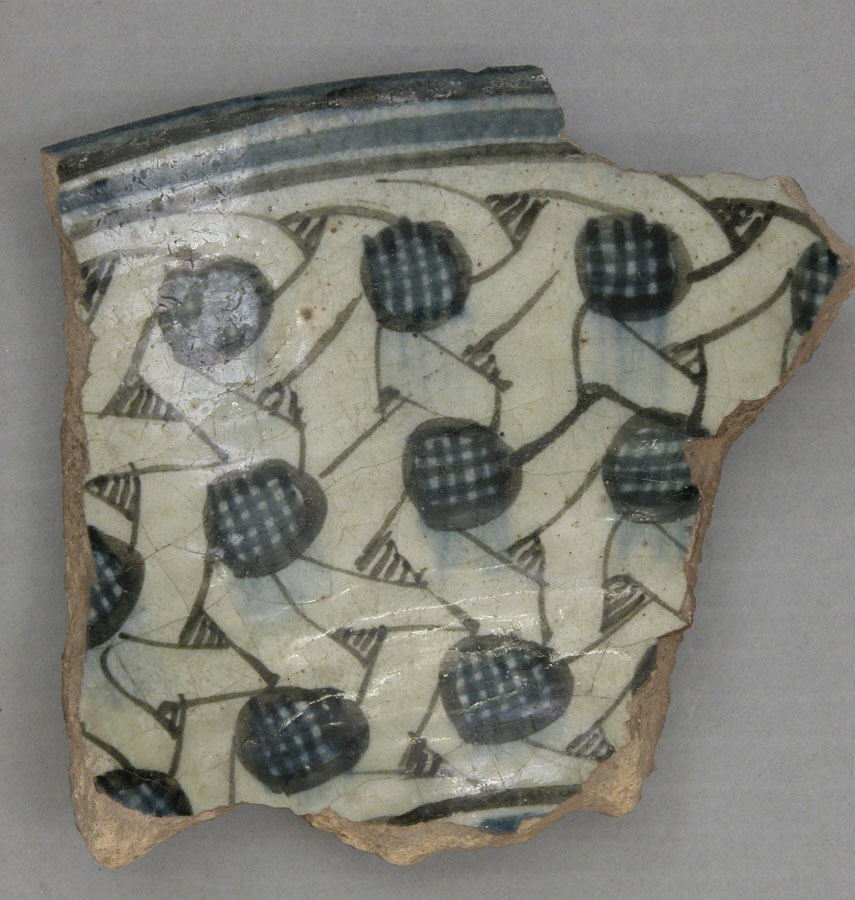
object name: ceramic fragment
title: Fragment of a Dish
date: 1301-1500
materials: glaze, stonepaste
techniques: painting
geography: egypt